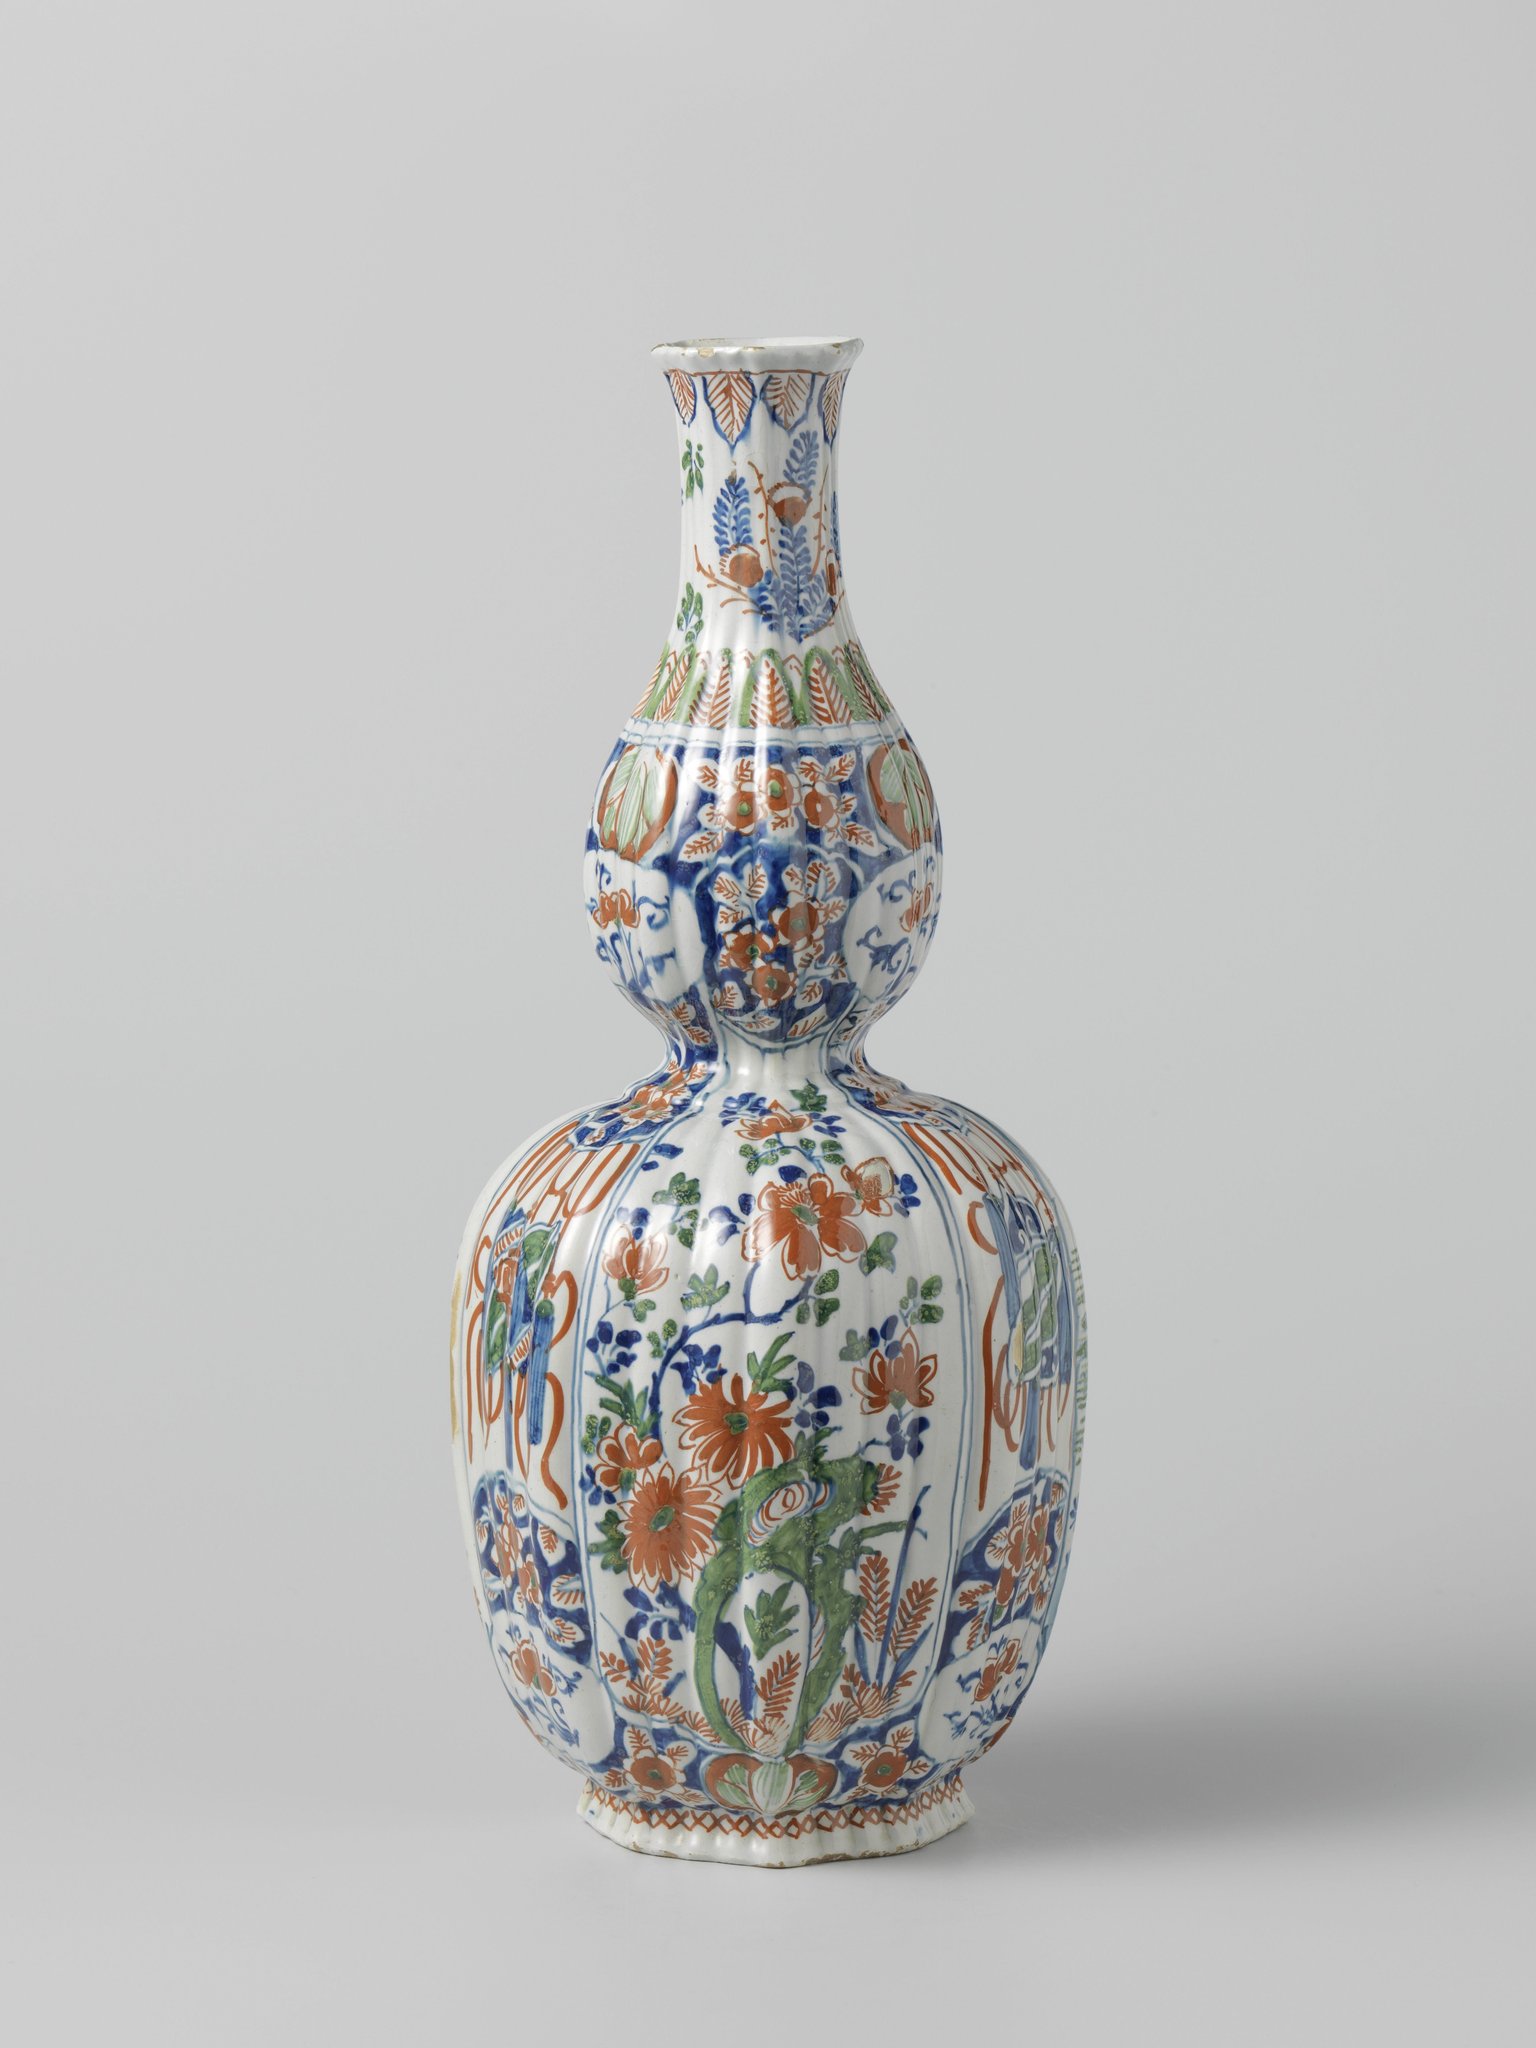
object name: bottle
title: kalebasvormige fles van veelkleurig beschilderde faïence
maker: Anonymous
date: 1720-1750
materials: faience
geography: delft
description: kalebasvormige fles van faience. Veelkleurig beschilderd met bloem- en bladornamenten.